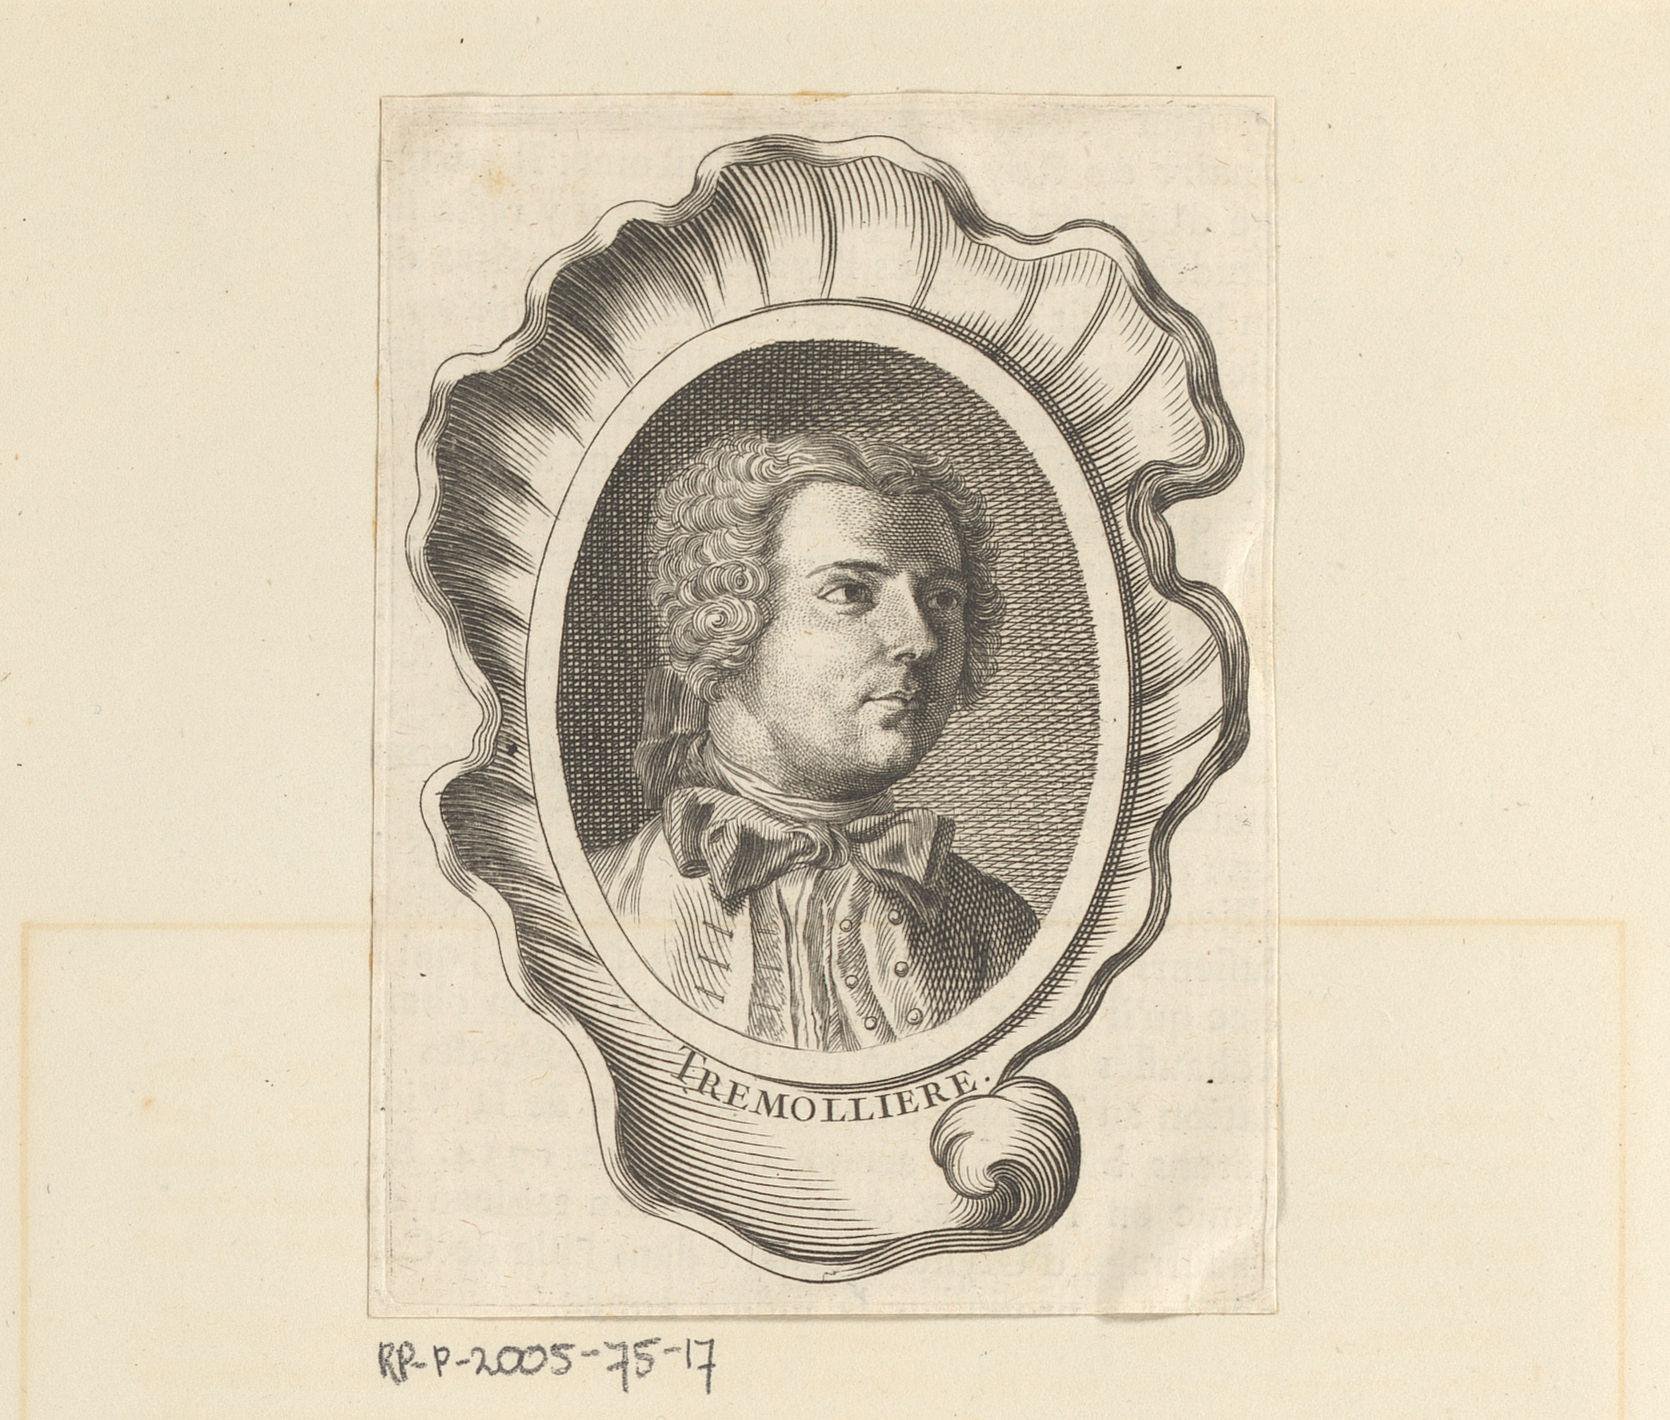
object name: print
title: Portret van Pierre Charles Trémolière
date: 1745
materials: paper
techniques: engraving, letterpress printing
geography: paris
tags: paris, painter, pierre charles trémolière, historical persons, portrait, self-portrait of painter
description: Prent uit: Dézallier d'Argenville, Antoine Joseph. Abrégé de la vie des plus fameux peintres. 4 dln. Parijs: De Bure l'aîné, 1745, dl. 2, p. 439. De samensteller heeft deze prent in het album geplakt als illustratie bij: Pilkington, Matthew en Johann Heinrich Füssli. A dictionary of painters, from the revival of the art to the present period. 4 dln. Londen: John Crowder, 1805, dl. 4, p. 566.